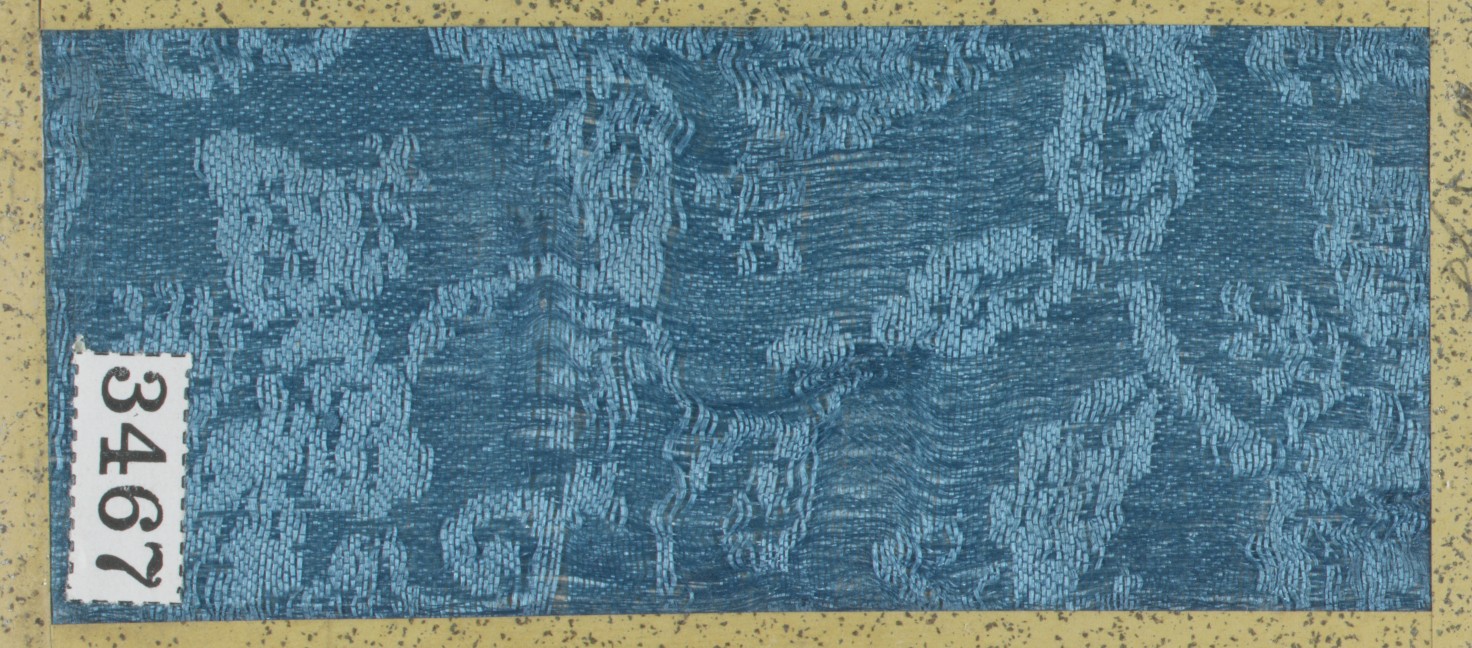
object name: sample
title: Textile Sample from Sample Book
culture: japanese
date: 1801-1900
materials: silk